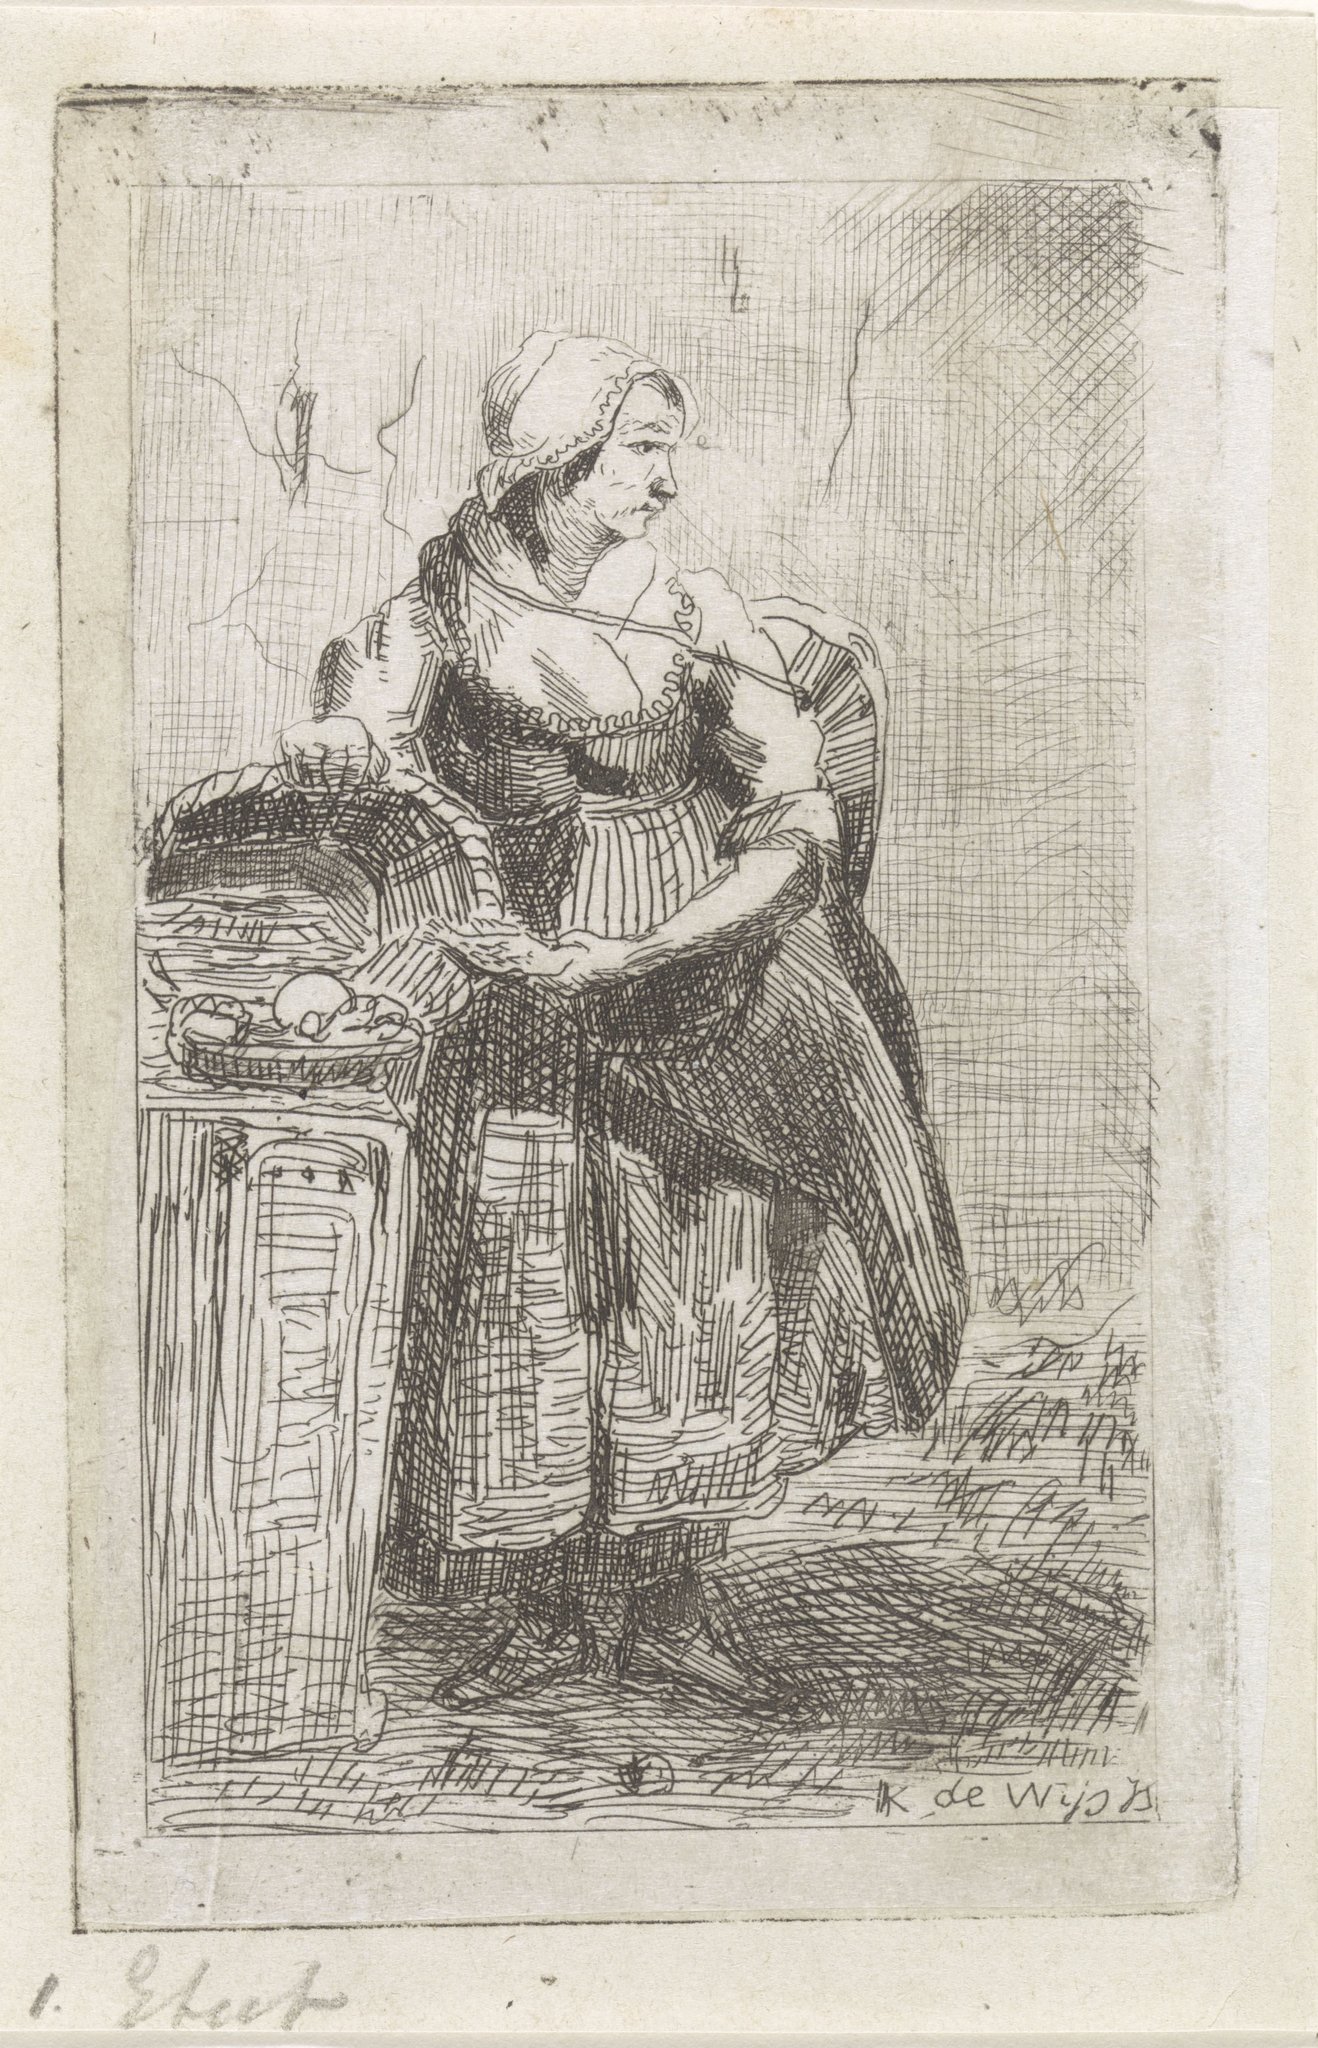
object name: print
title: Vissersvrouw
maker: kornelis jzn de wijs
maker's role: print maker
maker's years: 1832-1896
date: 1842-1884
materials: paper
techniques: etching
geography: netherlands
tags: fishes, container made of plant material other than wood: basket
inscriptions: collector's mark: Lugt 2228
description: Een vrouw toont een mand en houdt in de linkerhand een vis.